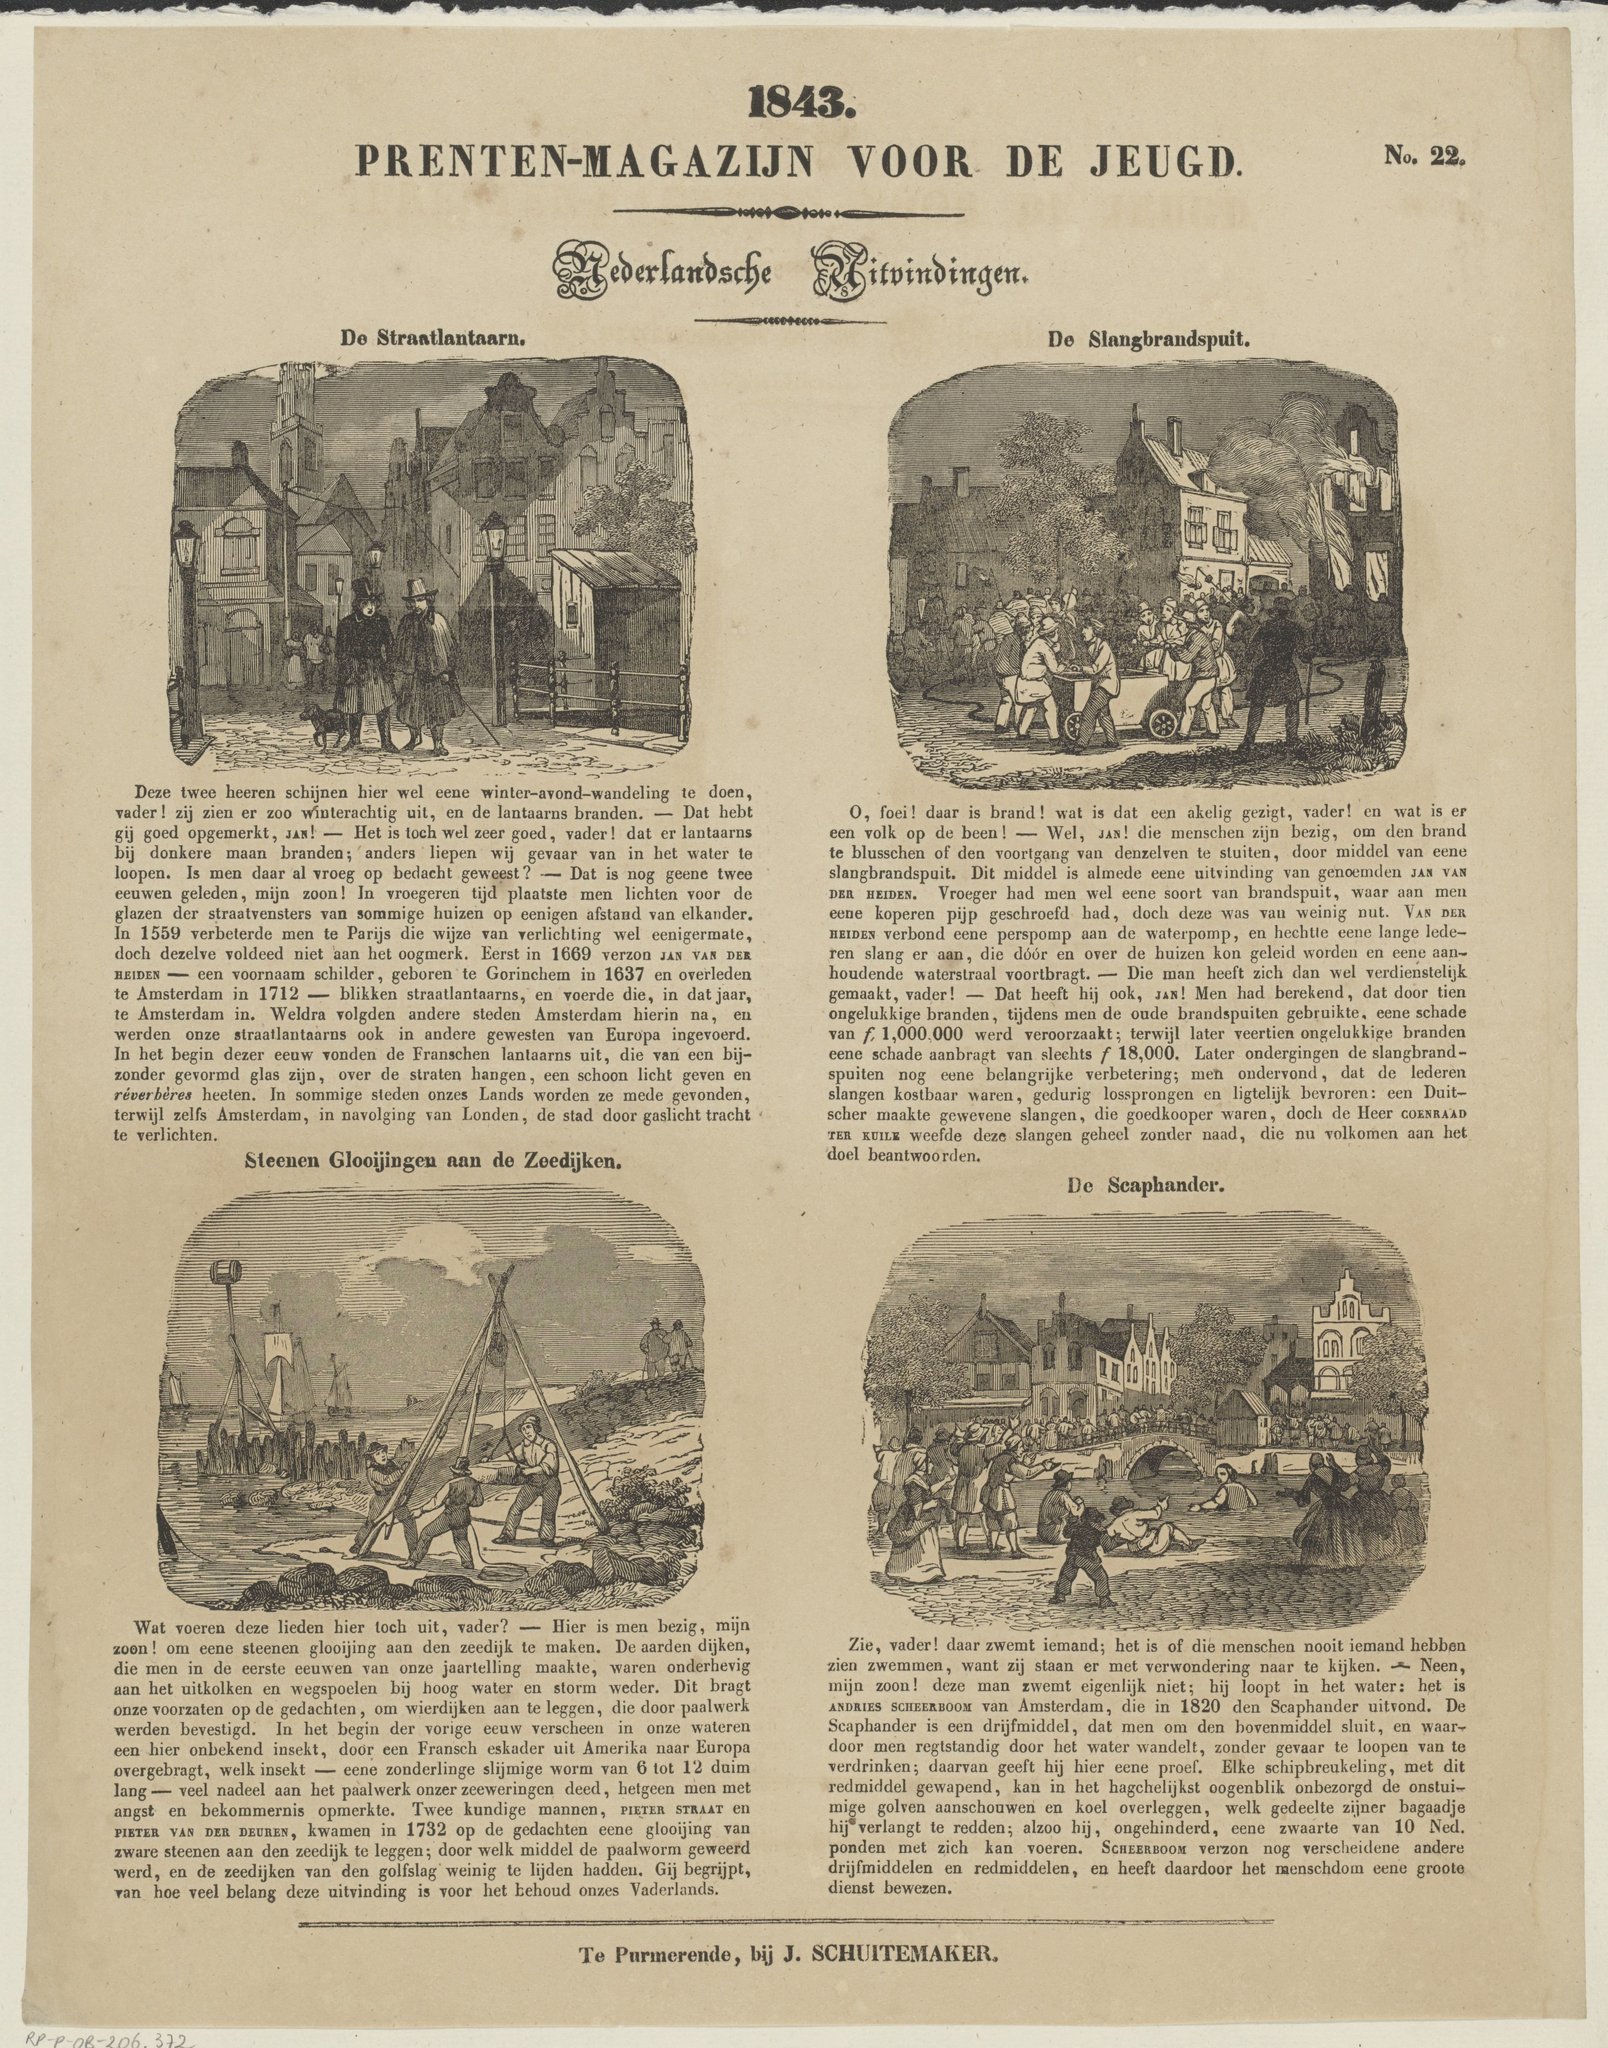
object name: popular print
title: Prenten-magazijn voor de jeugd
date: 1843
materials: paper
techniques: letterpress printing, engraving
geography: netherlands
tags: lifebelt, life-buoy, dikes, levee, fire-hose, street lighting, invention, discovery ~ science and technology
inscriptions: collector's mark: Lugt 2760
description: Blad met 4 voorstellingen van Nederlandse uitvindingen en ontdekkingen: de straatlantaarn, de slangbrandspuit, stenen glooiingen aan de zeedijken en de scaphander (zwemgordel). Boven elke voorstelling een titel en onder elke voorstelling een onderschrift. Genummerd rechtsboven: No. 22